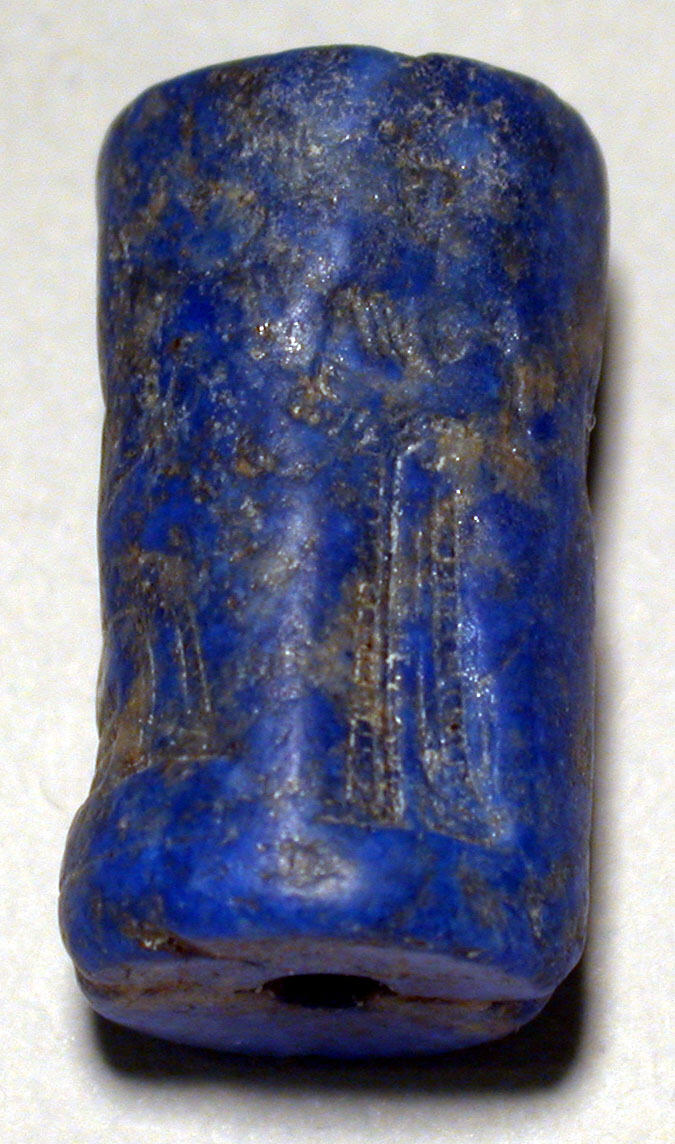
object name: cylinder seal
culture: neo-sumerian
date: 2112-2004 BCE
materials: lapis lazuli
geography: mesopotamia